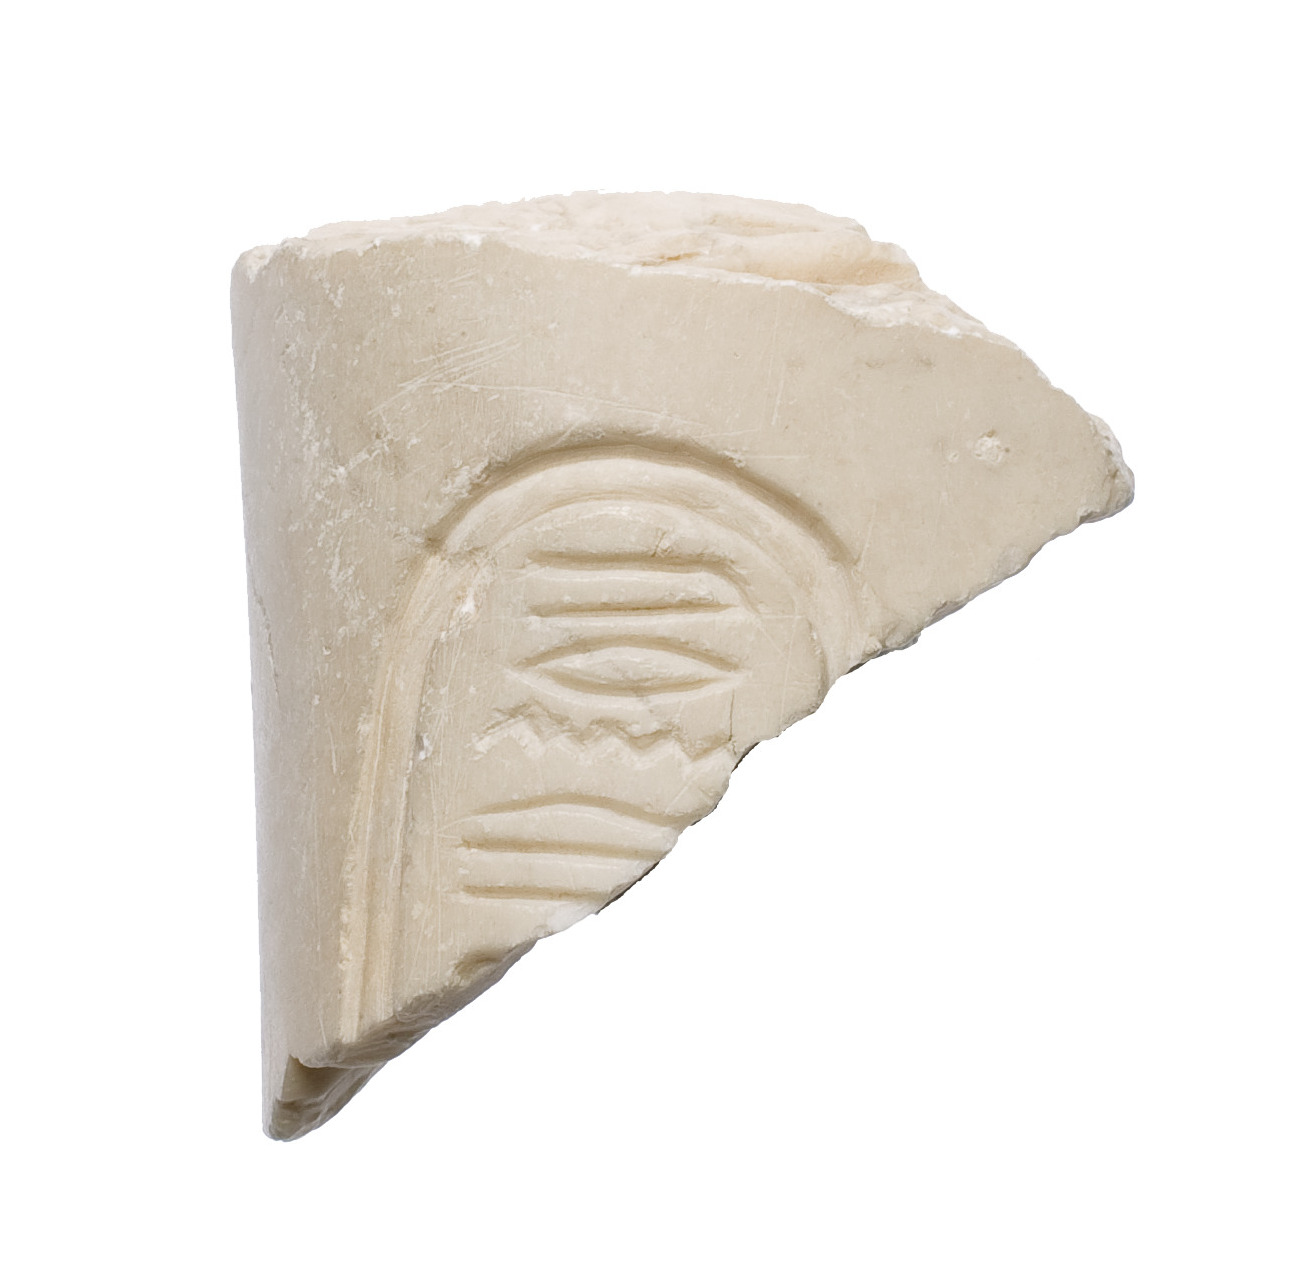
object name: forearm, aten cartouche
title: Forearm with Aten cartouche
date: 1353-1336 BCE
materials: limestone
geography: egypt